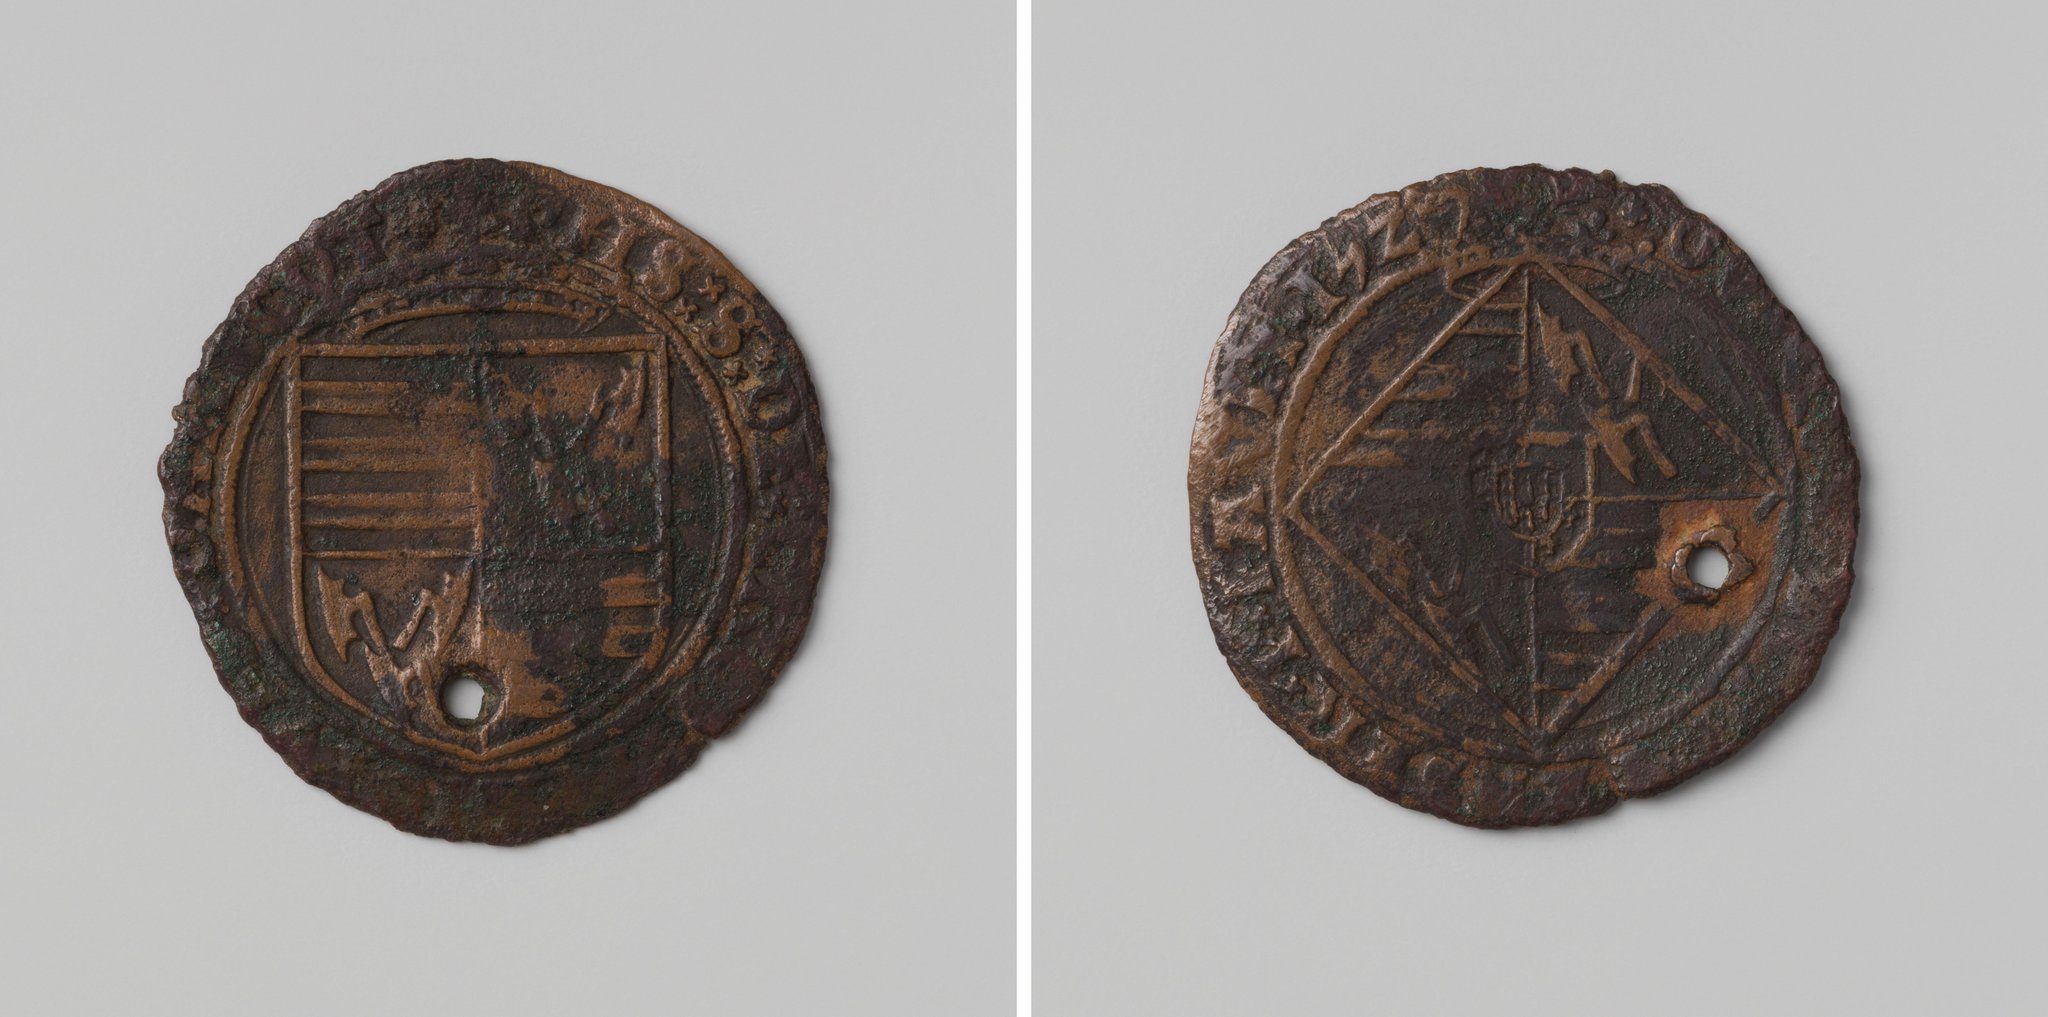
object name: jeton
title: Filips II van Croy, markies van Aarschot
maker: Anonymous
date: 1527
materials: copper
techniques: striking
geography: netherlands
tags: brussels, earl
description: Koperen penning met gat erin. Voorzijde: gekroond wapenschild binnen omschrift. Keerzijde: ruitvormig wapenschild binnen omschrift